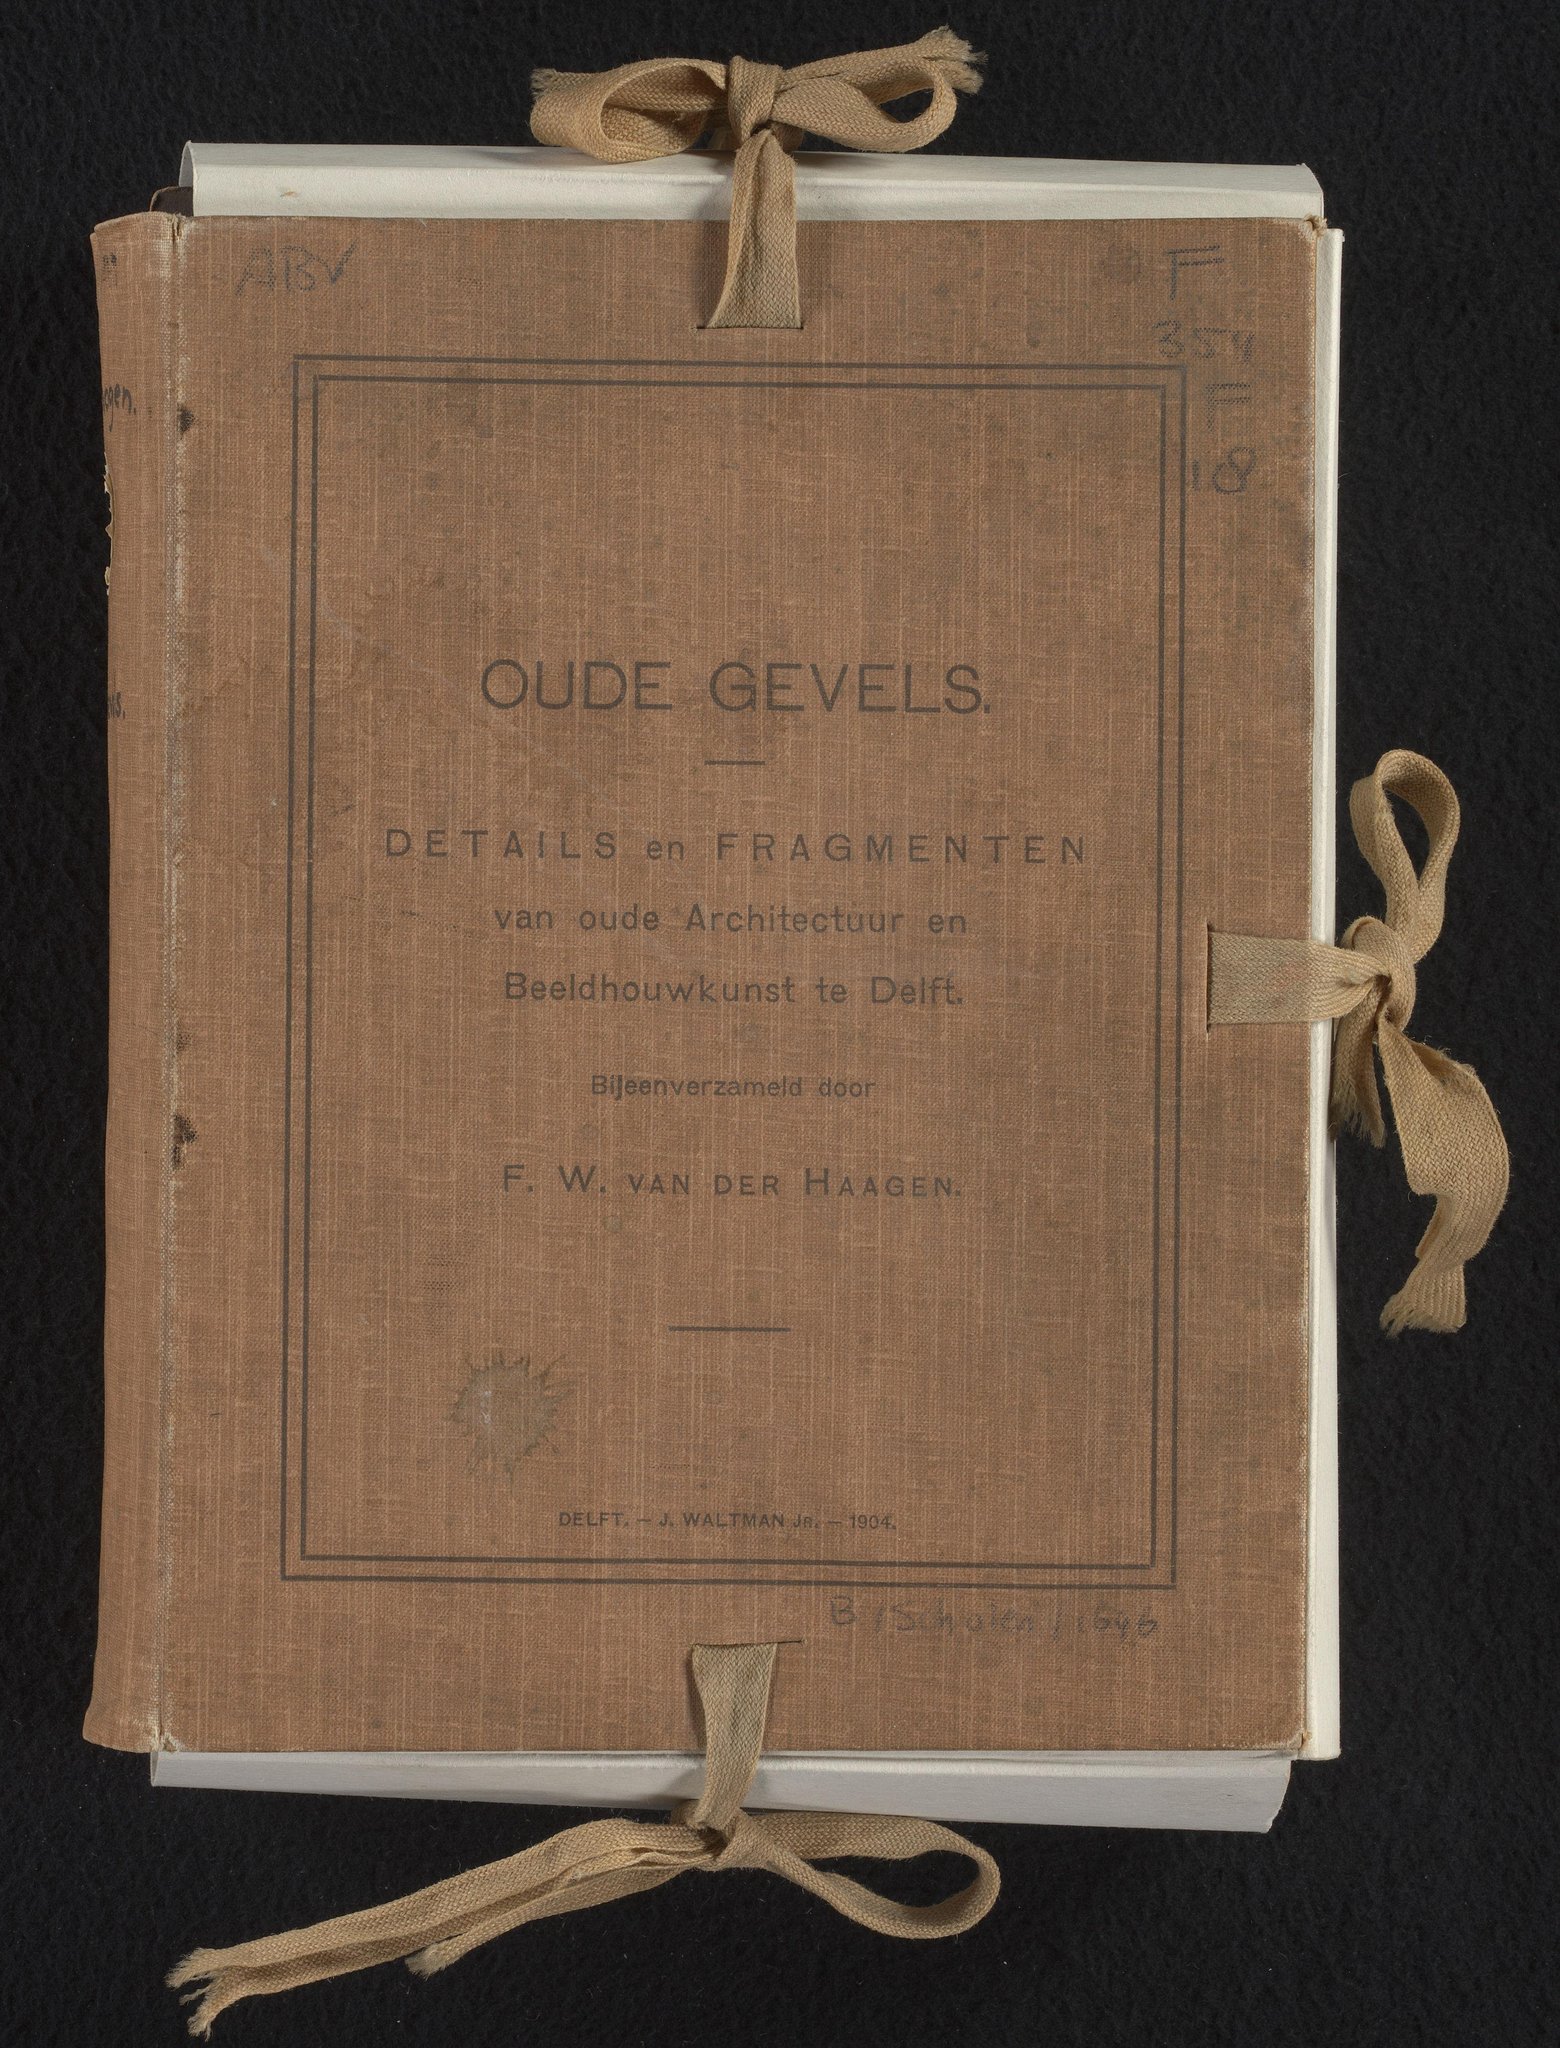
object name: portfolio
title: Oude gevels details en fragmenten van oude architectuur en beeldhouwkunst te Delft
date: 1904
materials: cardboard, linen, paper, photographic support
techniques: gelatin silver print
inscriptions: inscription: ‘v.d Haagen 9 E. 28 Oude gevels’